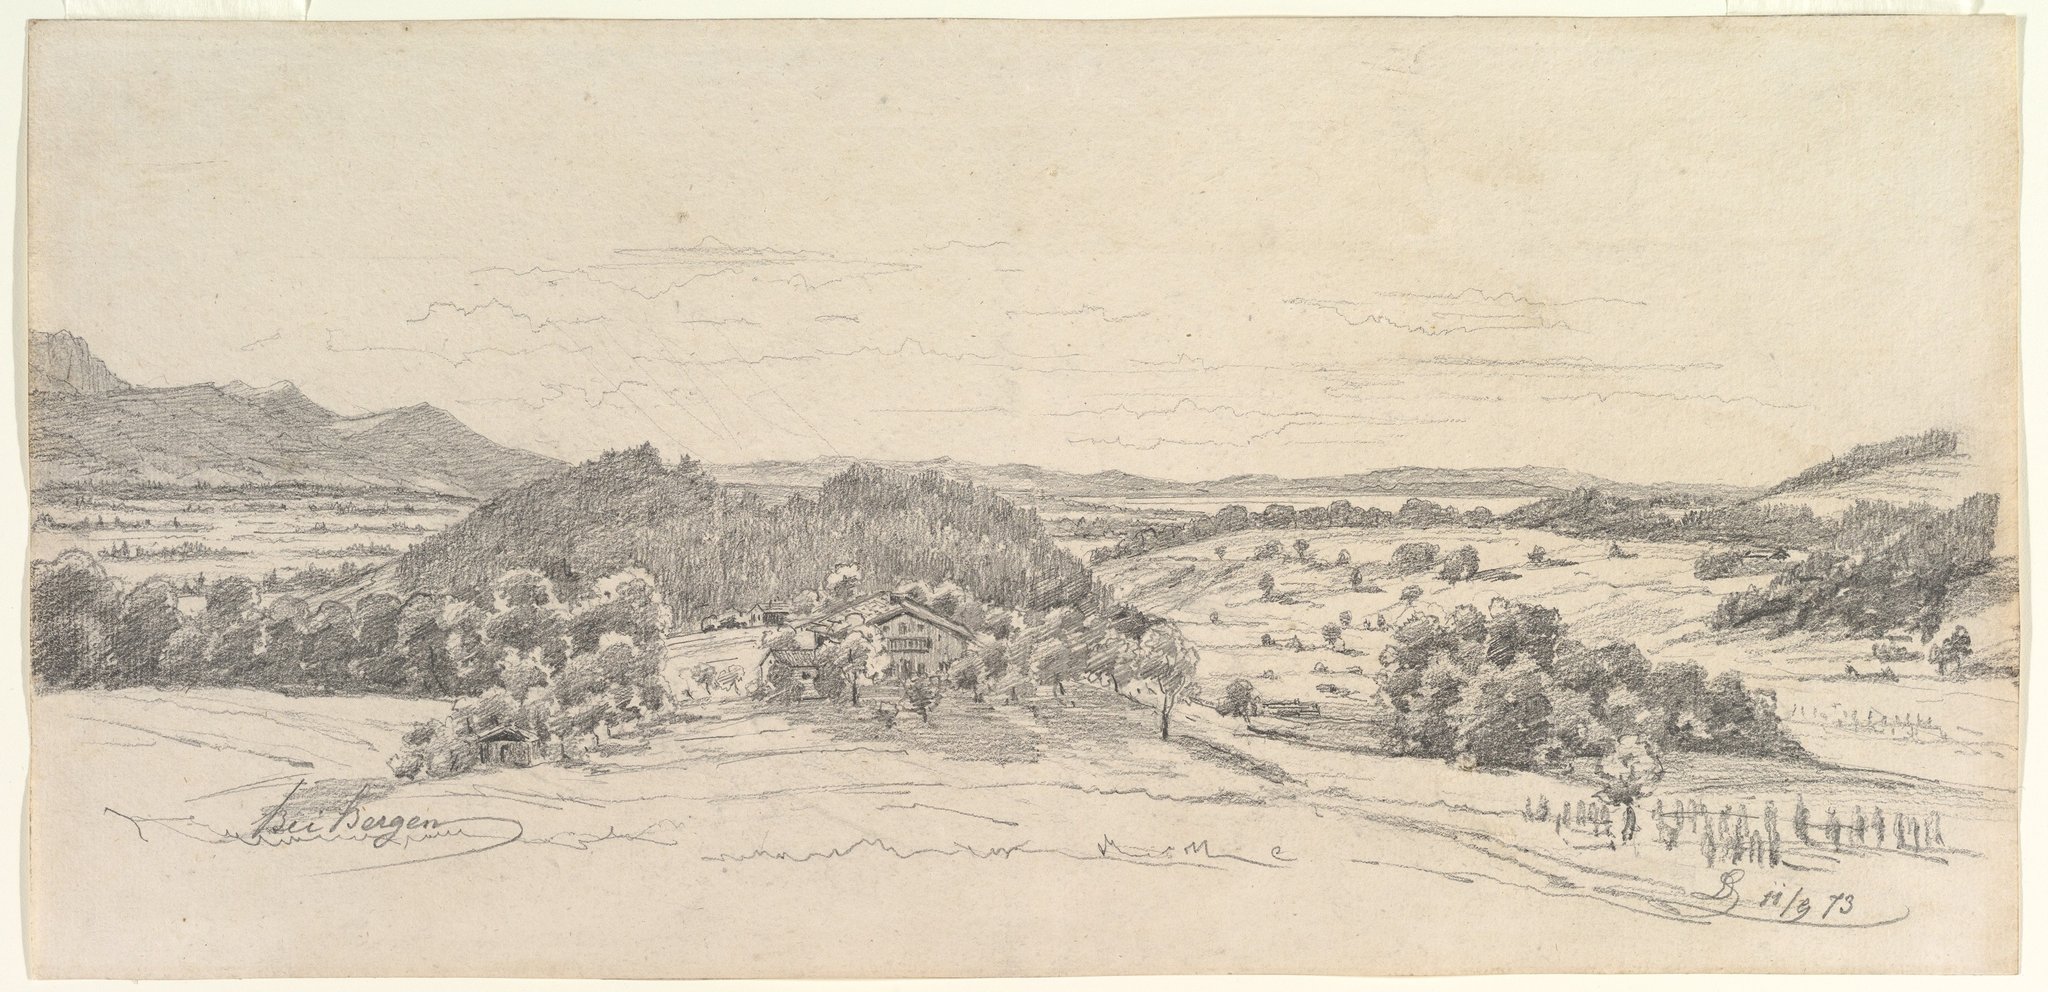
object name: drawing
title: Panoramic landscape near Bergen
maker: monogrammist ds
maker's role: artist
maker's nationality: norwegian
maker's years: 1873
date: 1813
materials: graphite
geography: norway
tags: landscapes,plants